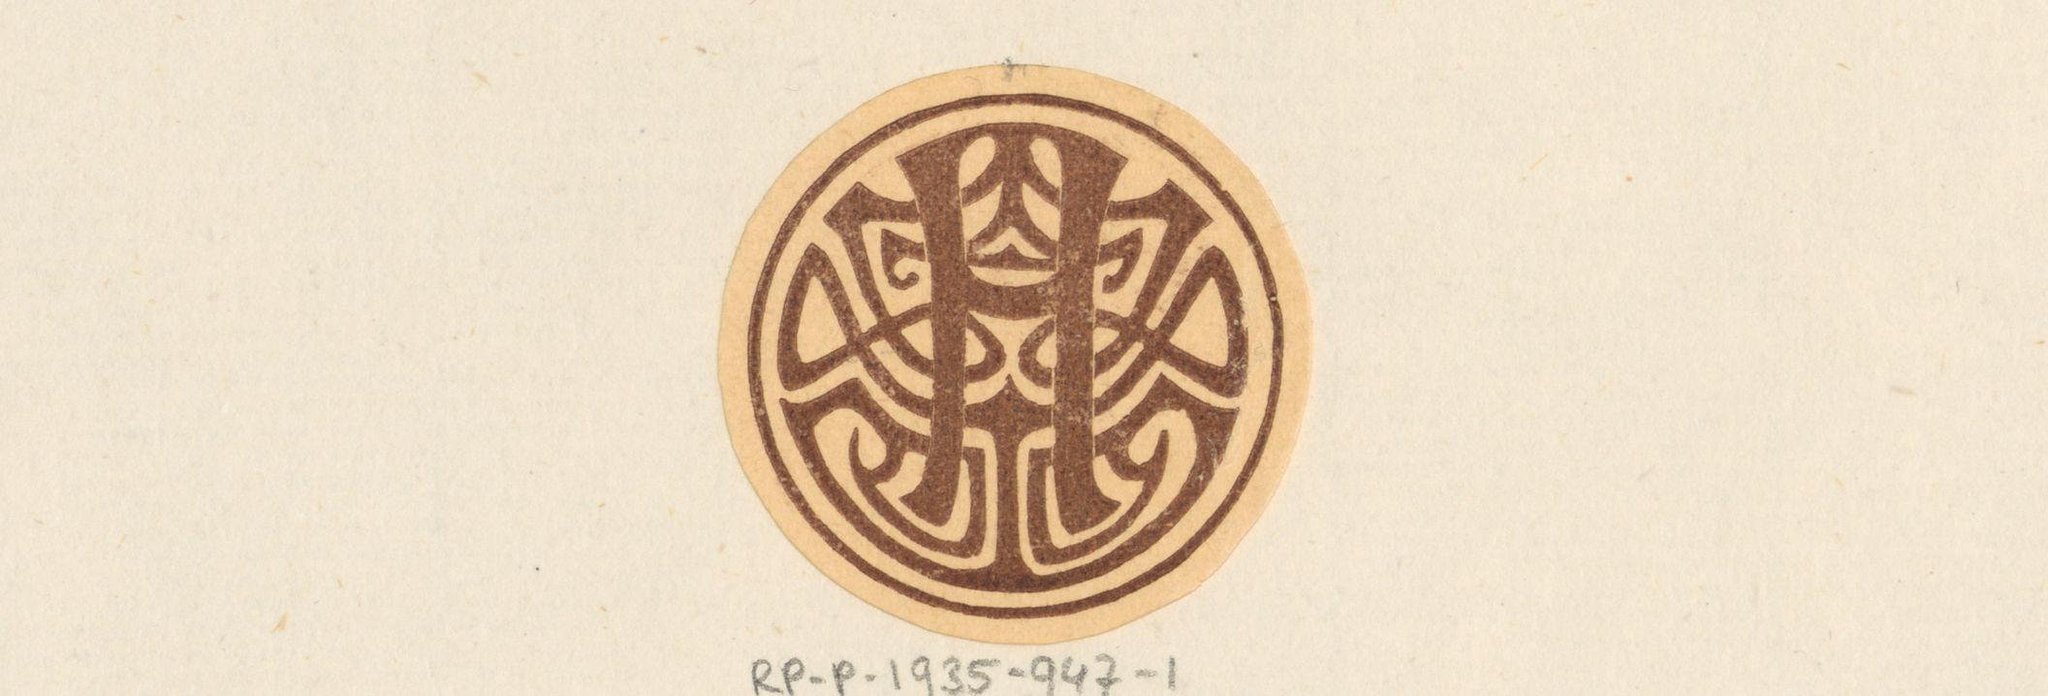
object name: bookplate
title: Ex libris van H.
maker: julie de graag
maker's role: draughtsman, print maker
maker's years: 1877-1924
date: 1887-1924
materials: paper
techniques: woodcut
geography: netherlands